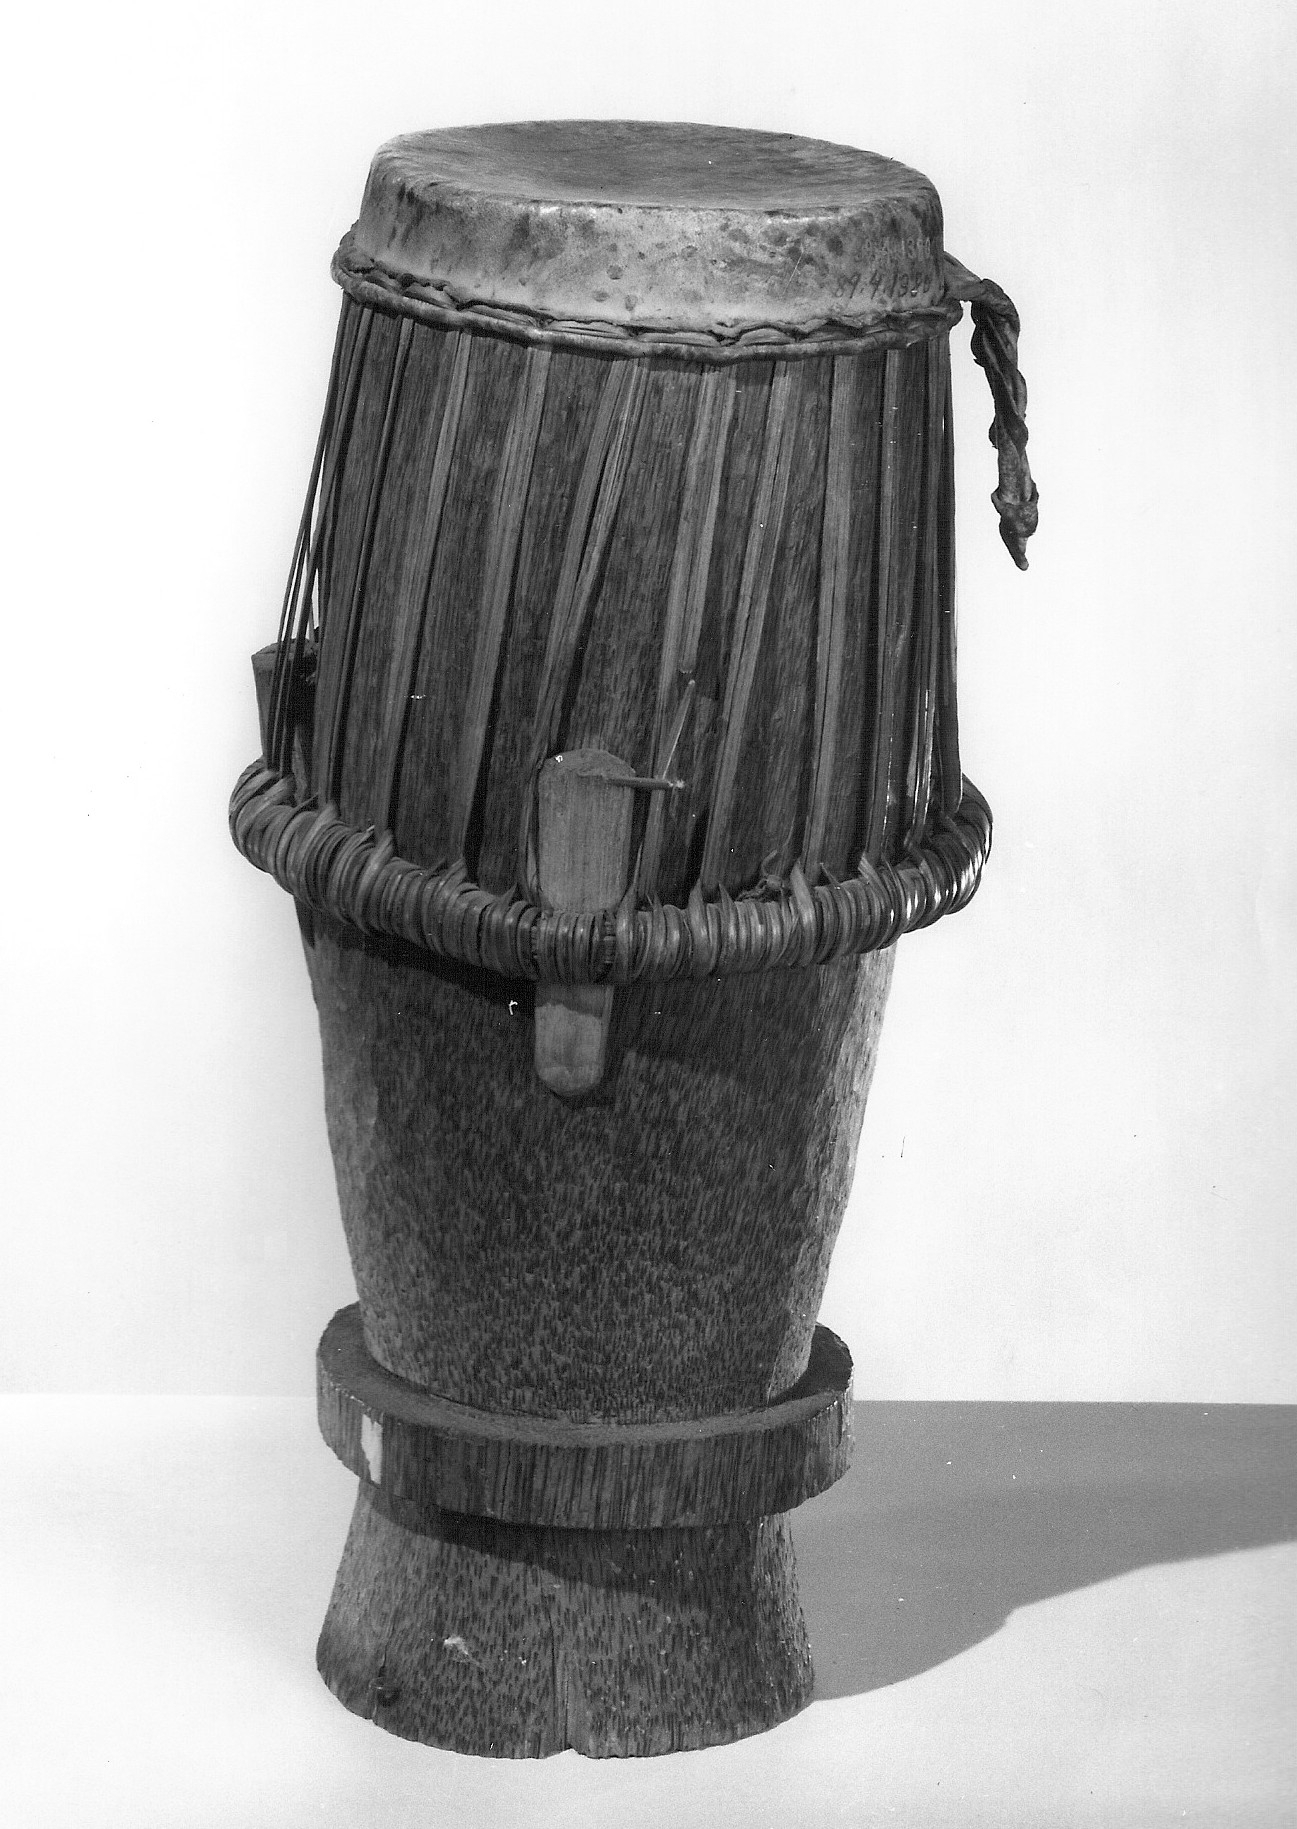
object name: drum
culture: wutu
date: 1801-1900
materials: wood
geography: cameroon